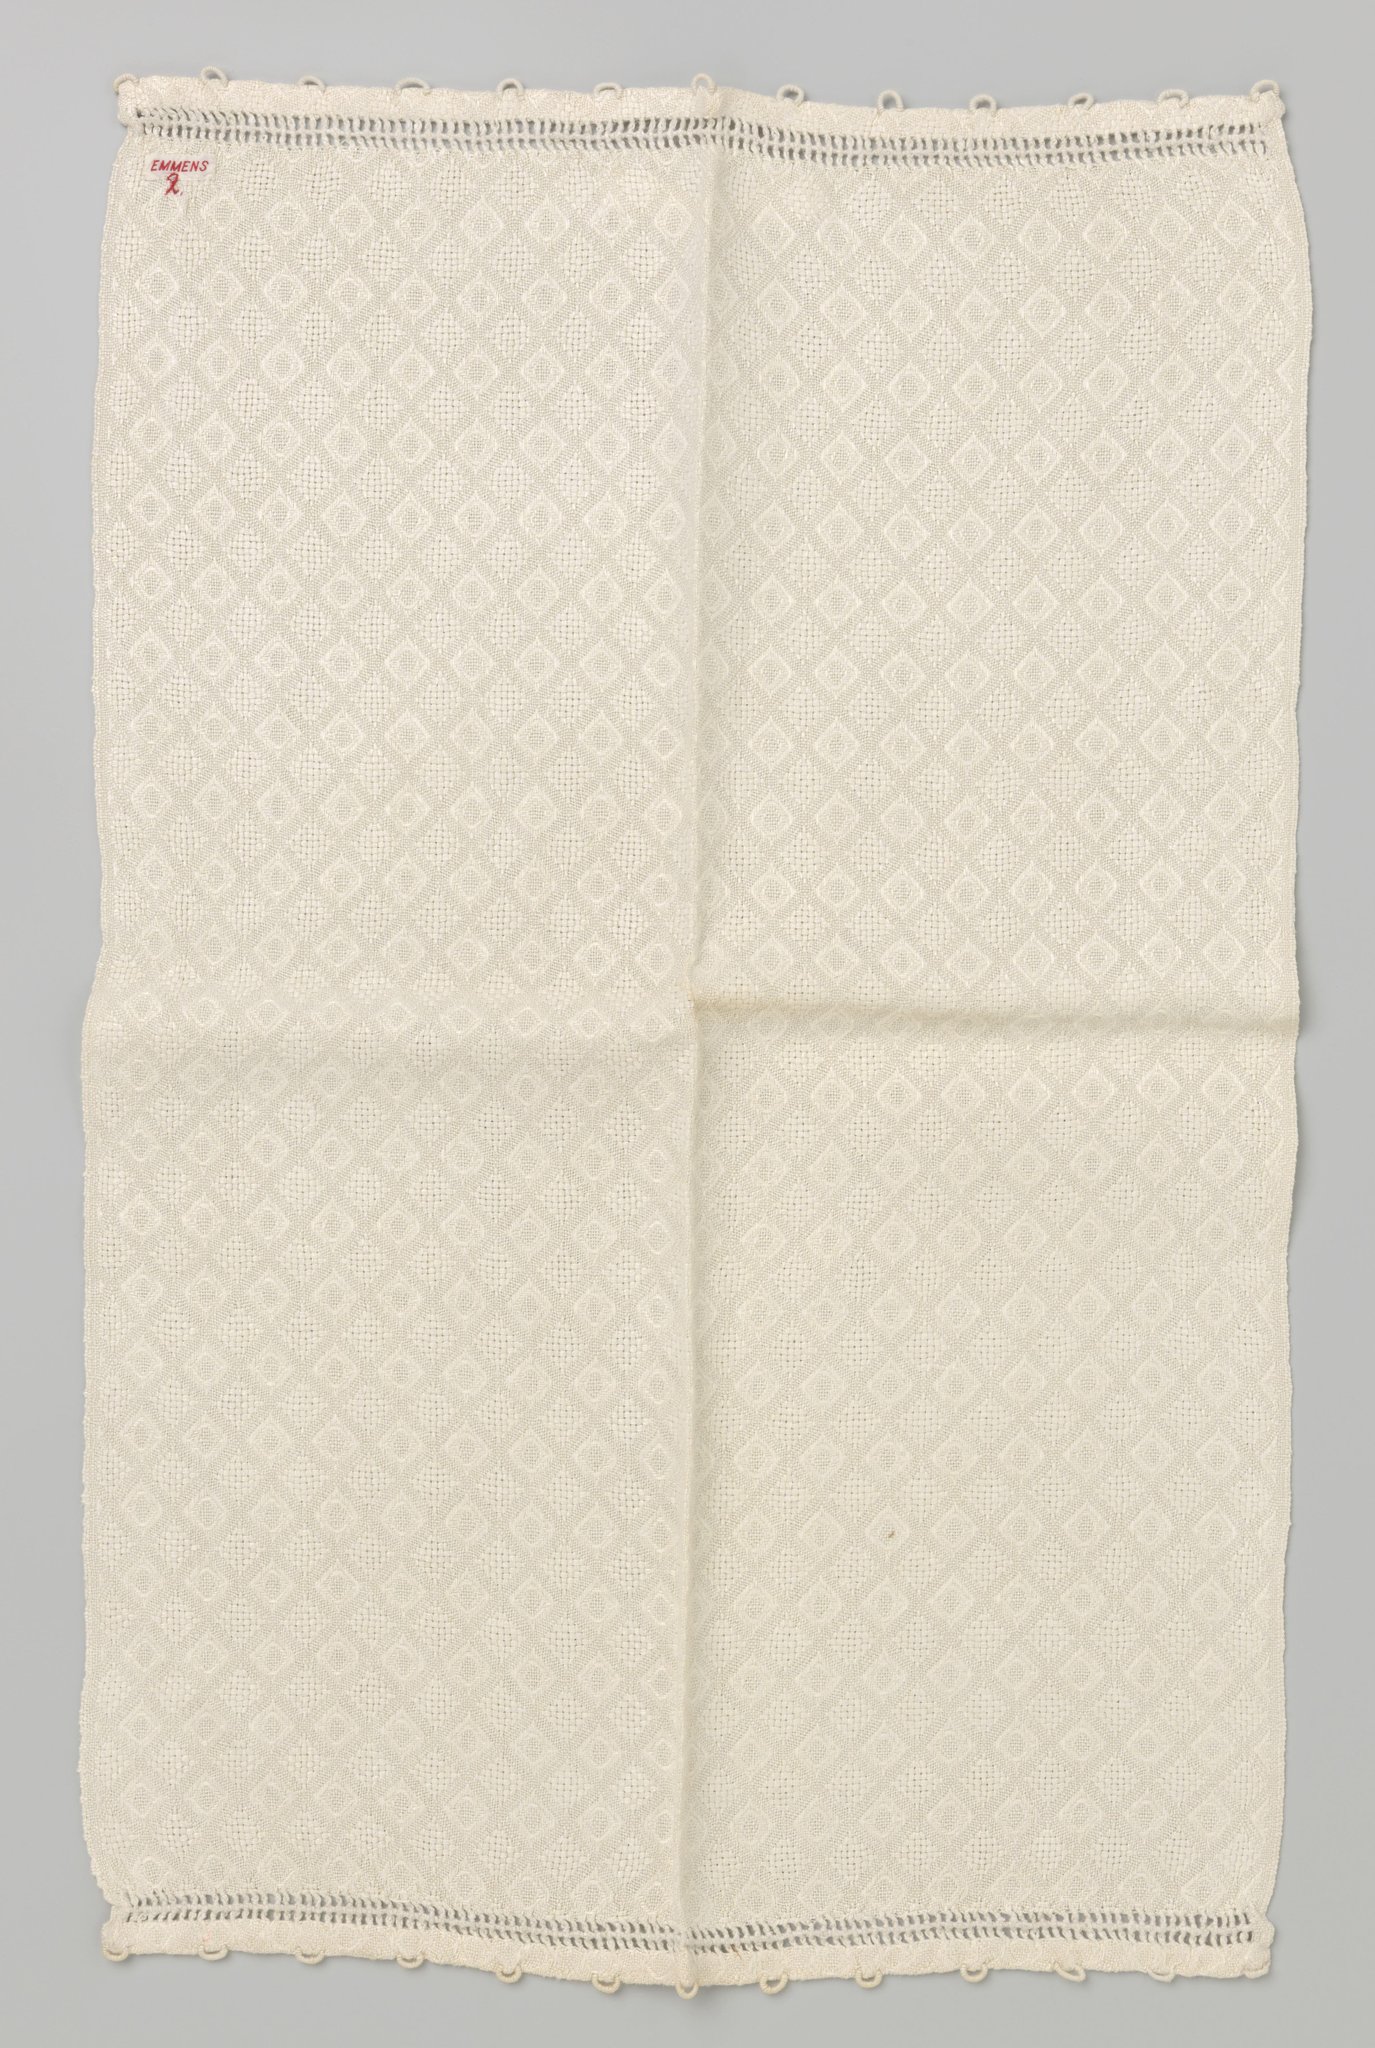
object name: towel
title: Handdoek van grof linnen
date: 1925-1950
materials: linen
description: Handdoek van grof linnen met een rasterwerkpatroon in reliëf en boven en onder met open zomen, versierd met grote picots; in rood gemerkt: Emmens en 8. Zie: BK-1972-169-a.